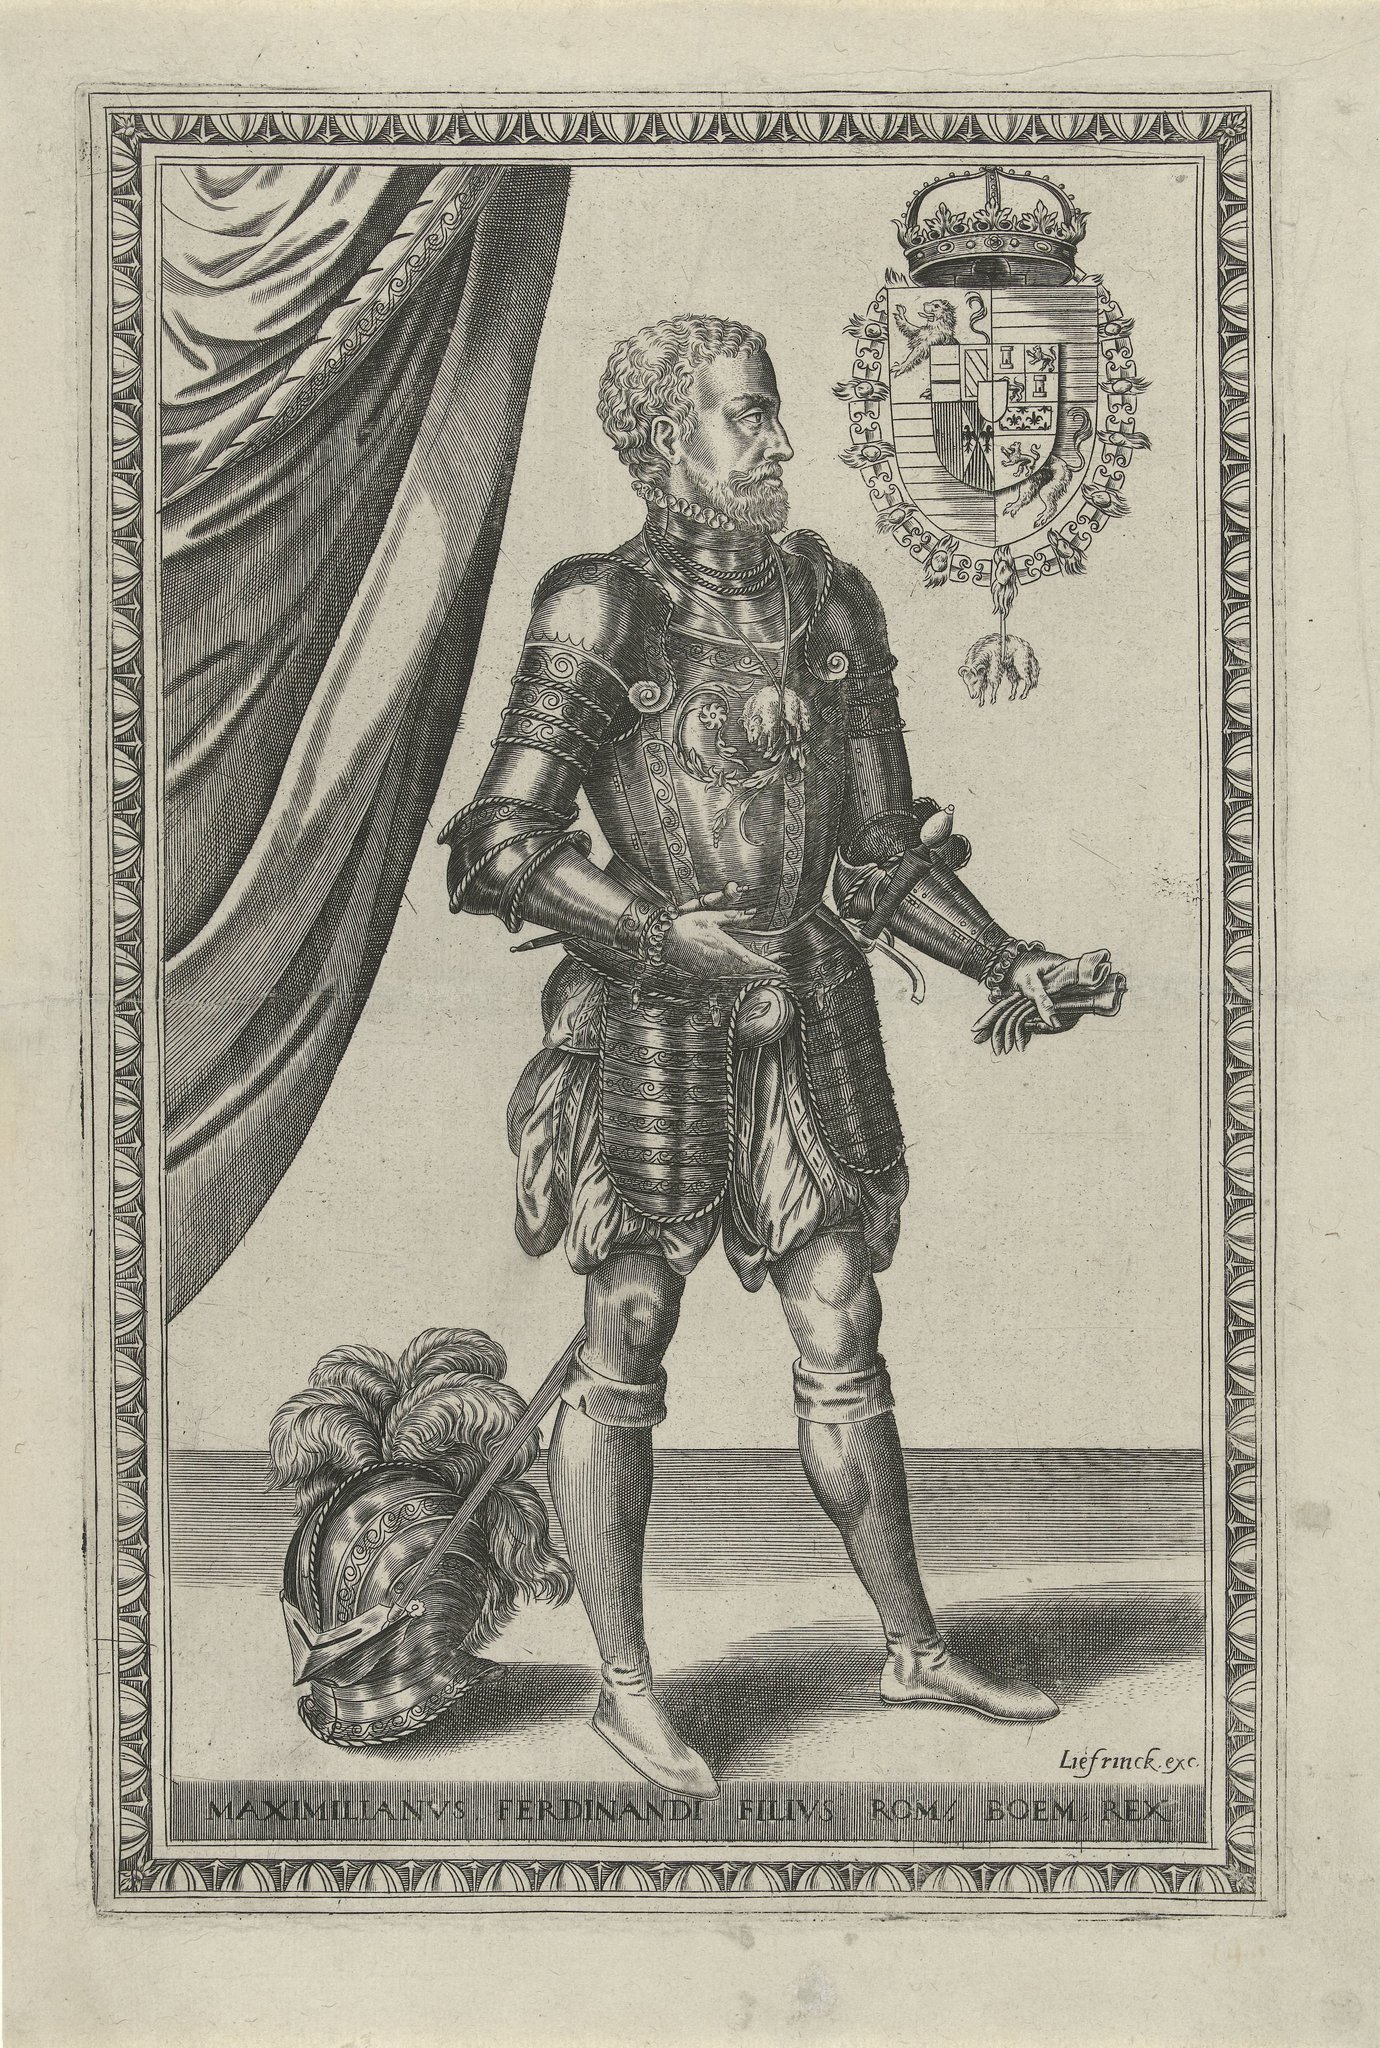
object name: print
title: Portret van keizer Maximiliaan II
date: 1546-1562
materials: paper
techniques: engraving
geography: antwerp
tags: maximiliaan ii (keizer van heilige roomse rijk)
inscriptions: collector's mark: Lugt 2760, collector's mark: Lugt 2228, collector's mark: Lugt 151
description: Portret van Maximiliaan II, Duits keizer, ten voeten uit naar rechts gekleed in harnas, in de linkerhand een paar handschoenen. Rechtsboven zijn wapenschild omgeven door de orde van het Gulden Vlies. Linksonder op de grond een helm.